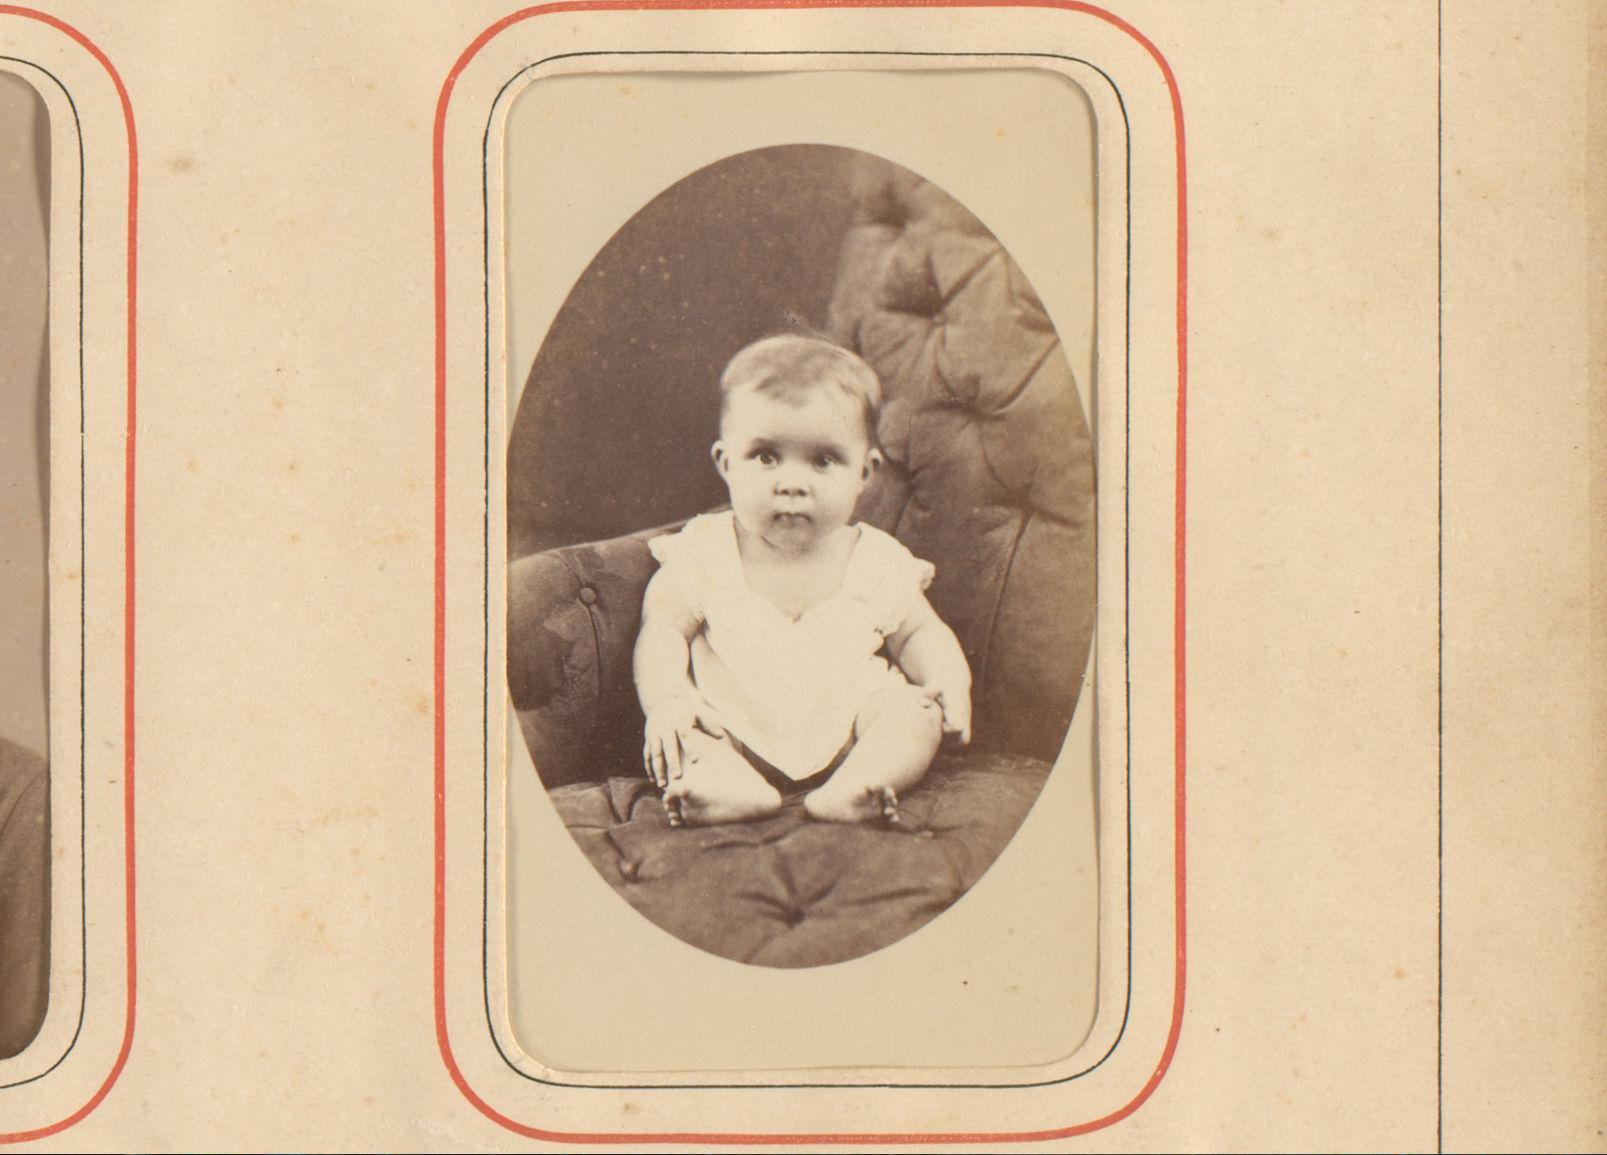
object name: album leaf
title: Portret van een onbekende baby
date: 1870-1890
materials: cardboard, paper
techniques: albumen print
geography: batavia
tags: anonymous historical person portrayed